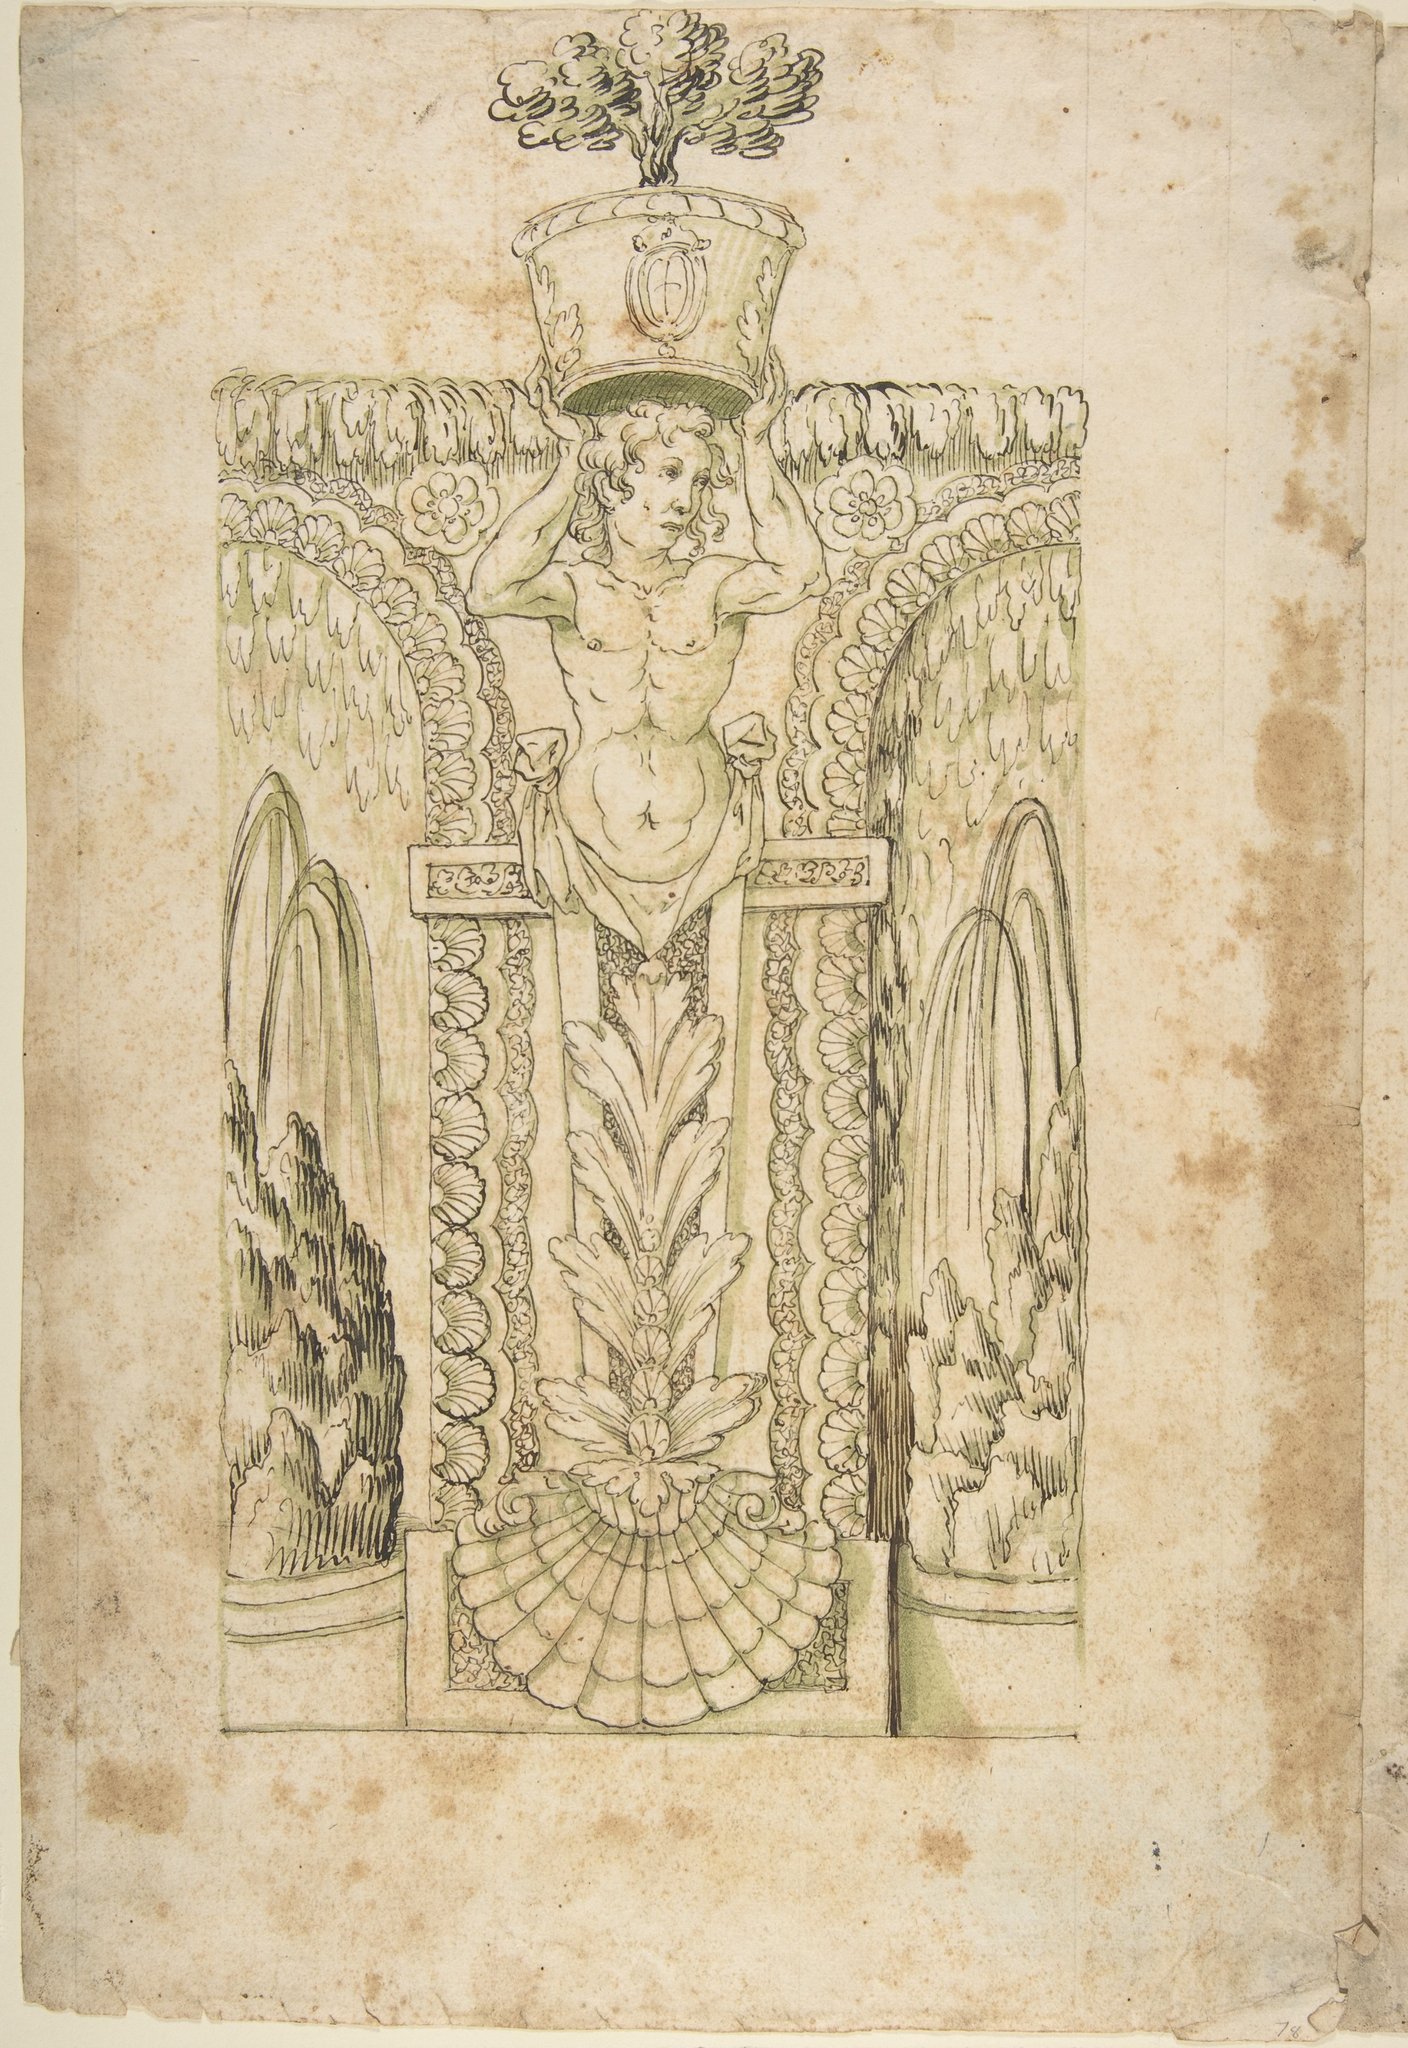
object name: drawing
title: Design for a Wall Fountain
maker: anonymous, italian, lombard, 16th century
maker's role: artist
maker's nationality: italian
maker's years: 1500-1600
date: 1550-1620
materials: graphite, ink, drawing material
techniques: brush, pen, wash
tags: human figures,architecture,fountains,palmettes